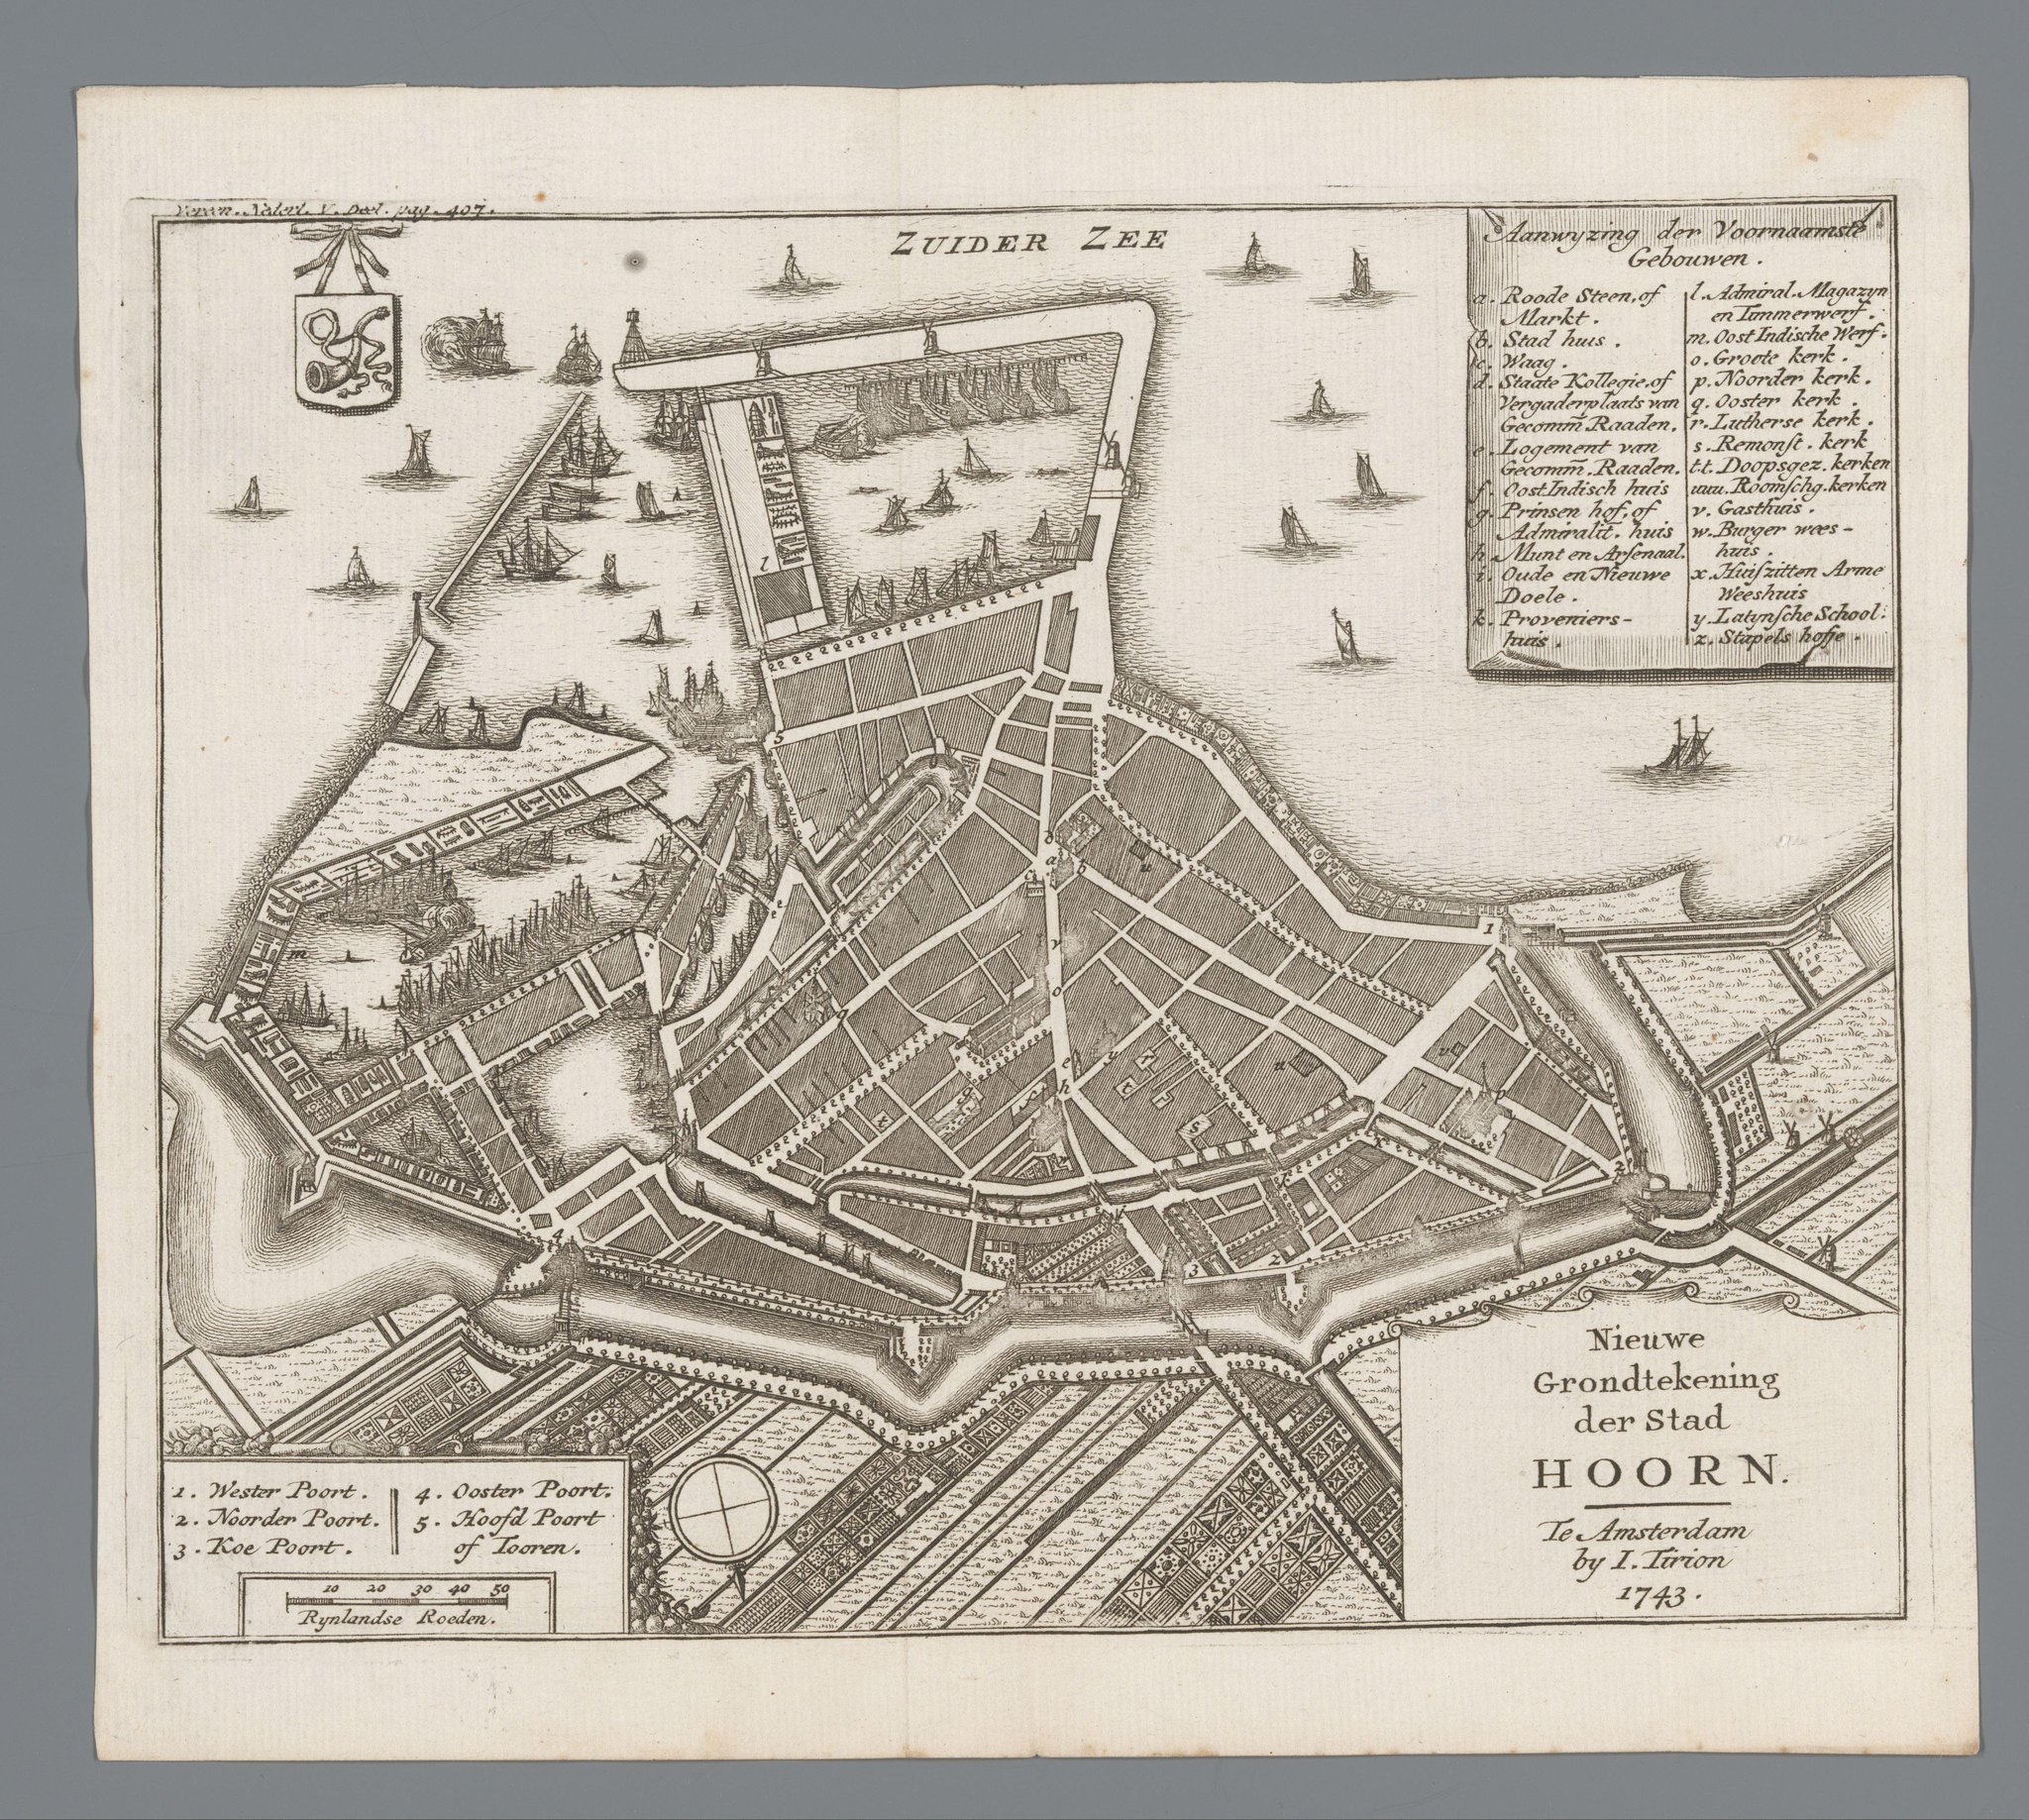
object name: print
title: Plattegrond van de stad Hoorn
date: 1743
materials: paper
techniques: engraving, etching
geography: amsterdam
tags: maps of cities, hoorn (north holland)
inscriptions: collector's mark: Lugt 2228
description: Prent uit: Wagenaar, Jan. Tegenwoordige staat der Vereenigde Nederlanden (...). 21 dln. Amsterdam: Isaak Tirion, 1729-1795, dl. 5, p. 406-407.